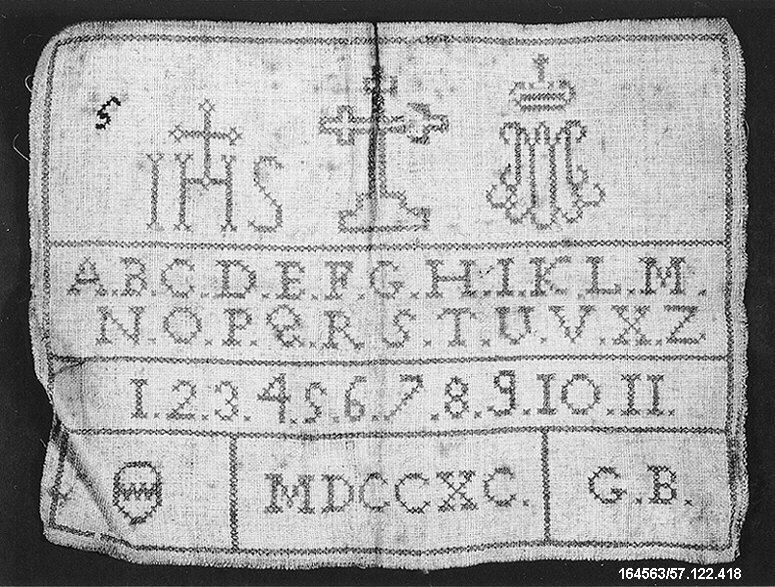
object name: sampler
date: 1790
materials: linen, silk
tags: cross